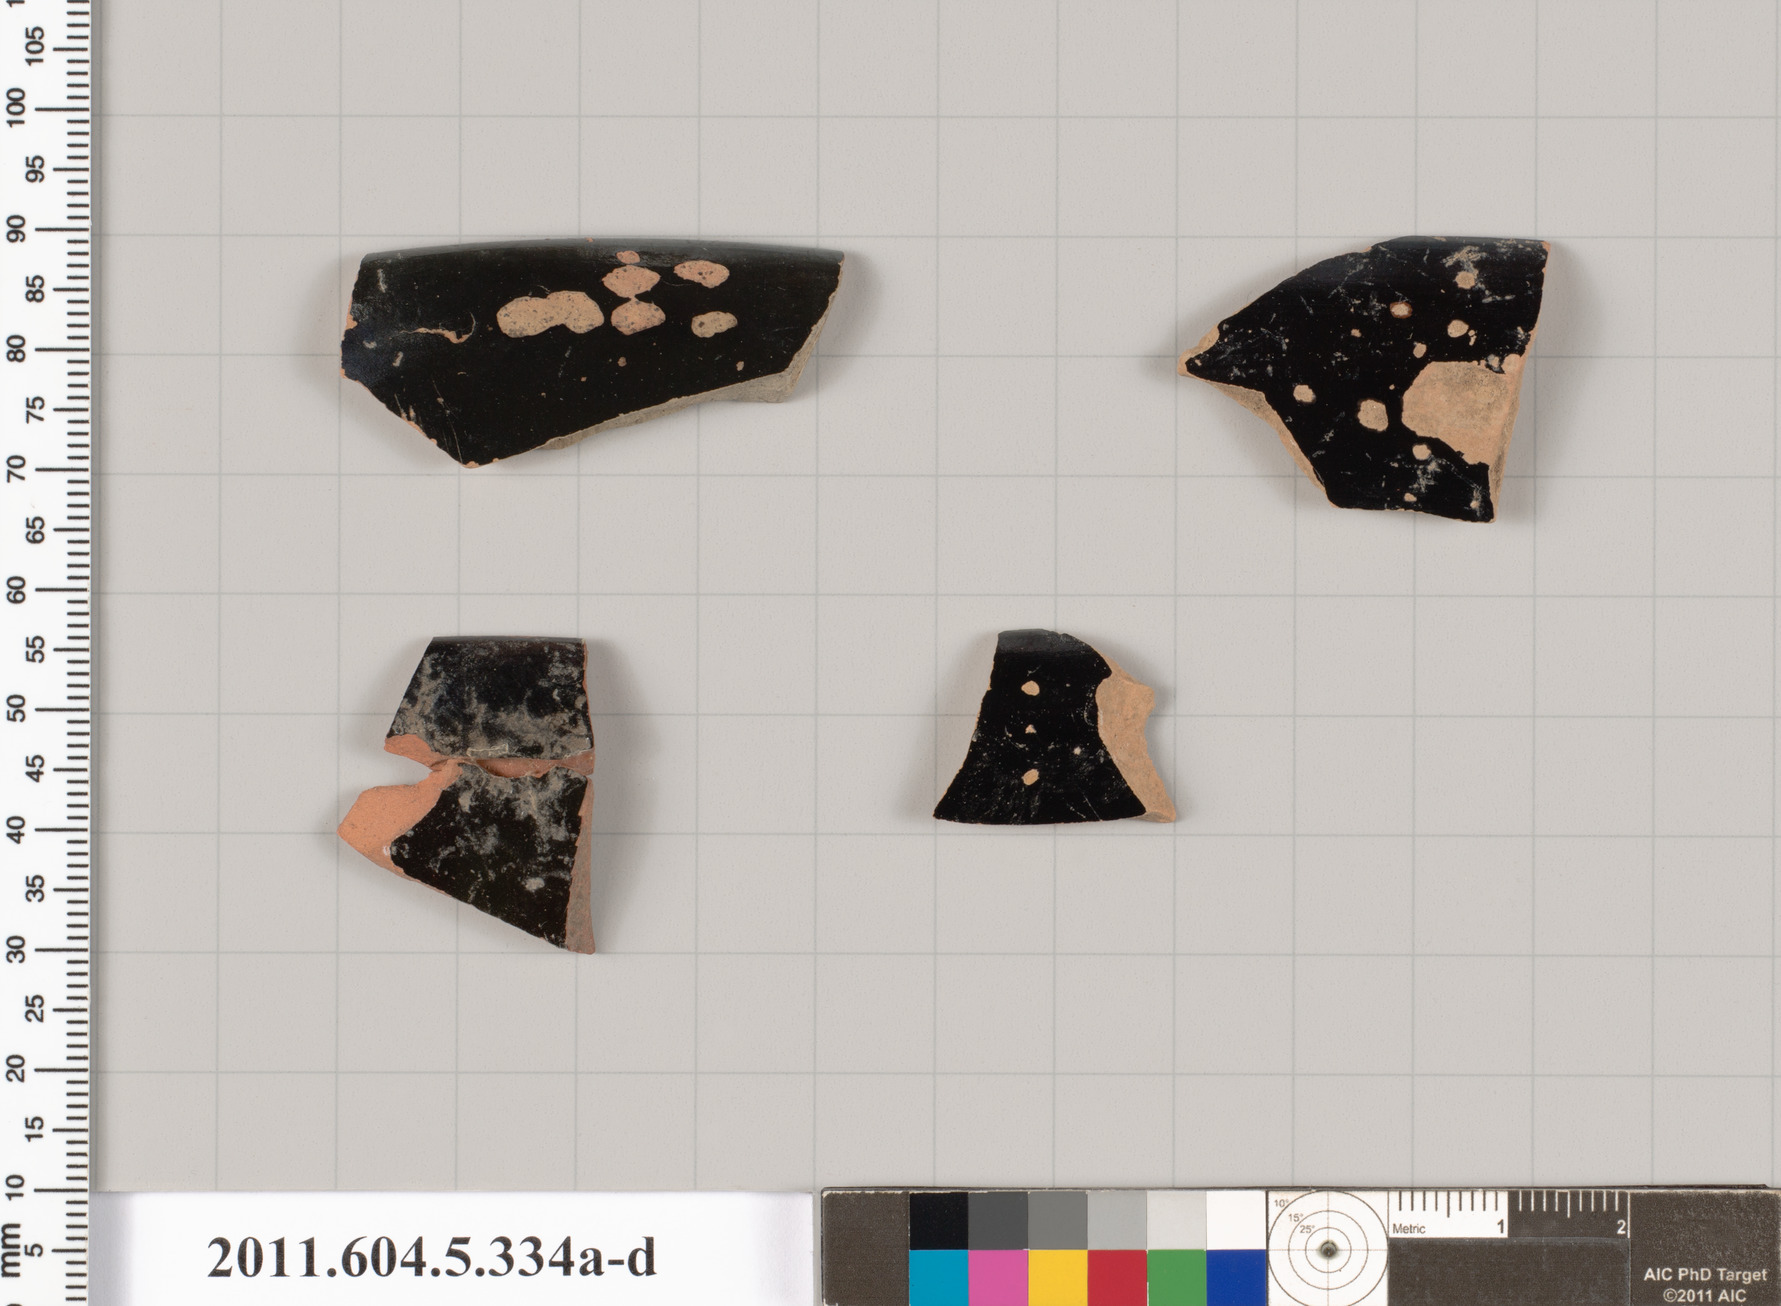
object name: kylix fragment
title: Terracotta rim fragments of kylikes (drinking cups)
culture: greek, attic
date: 600-401 BCE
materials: terracotta